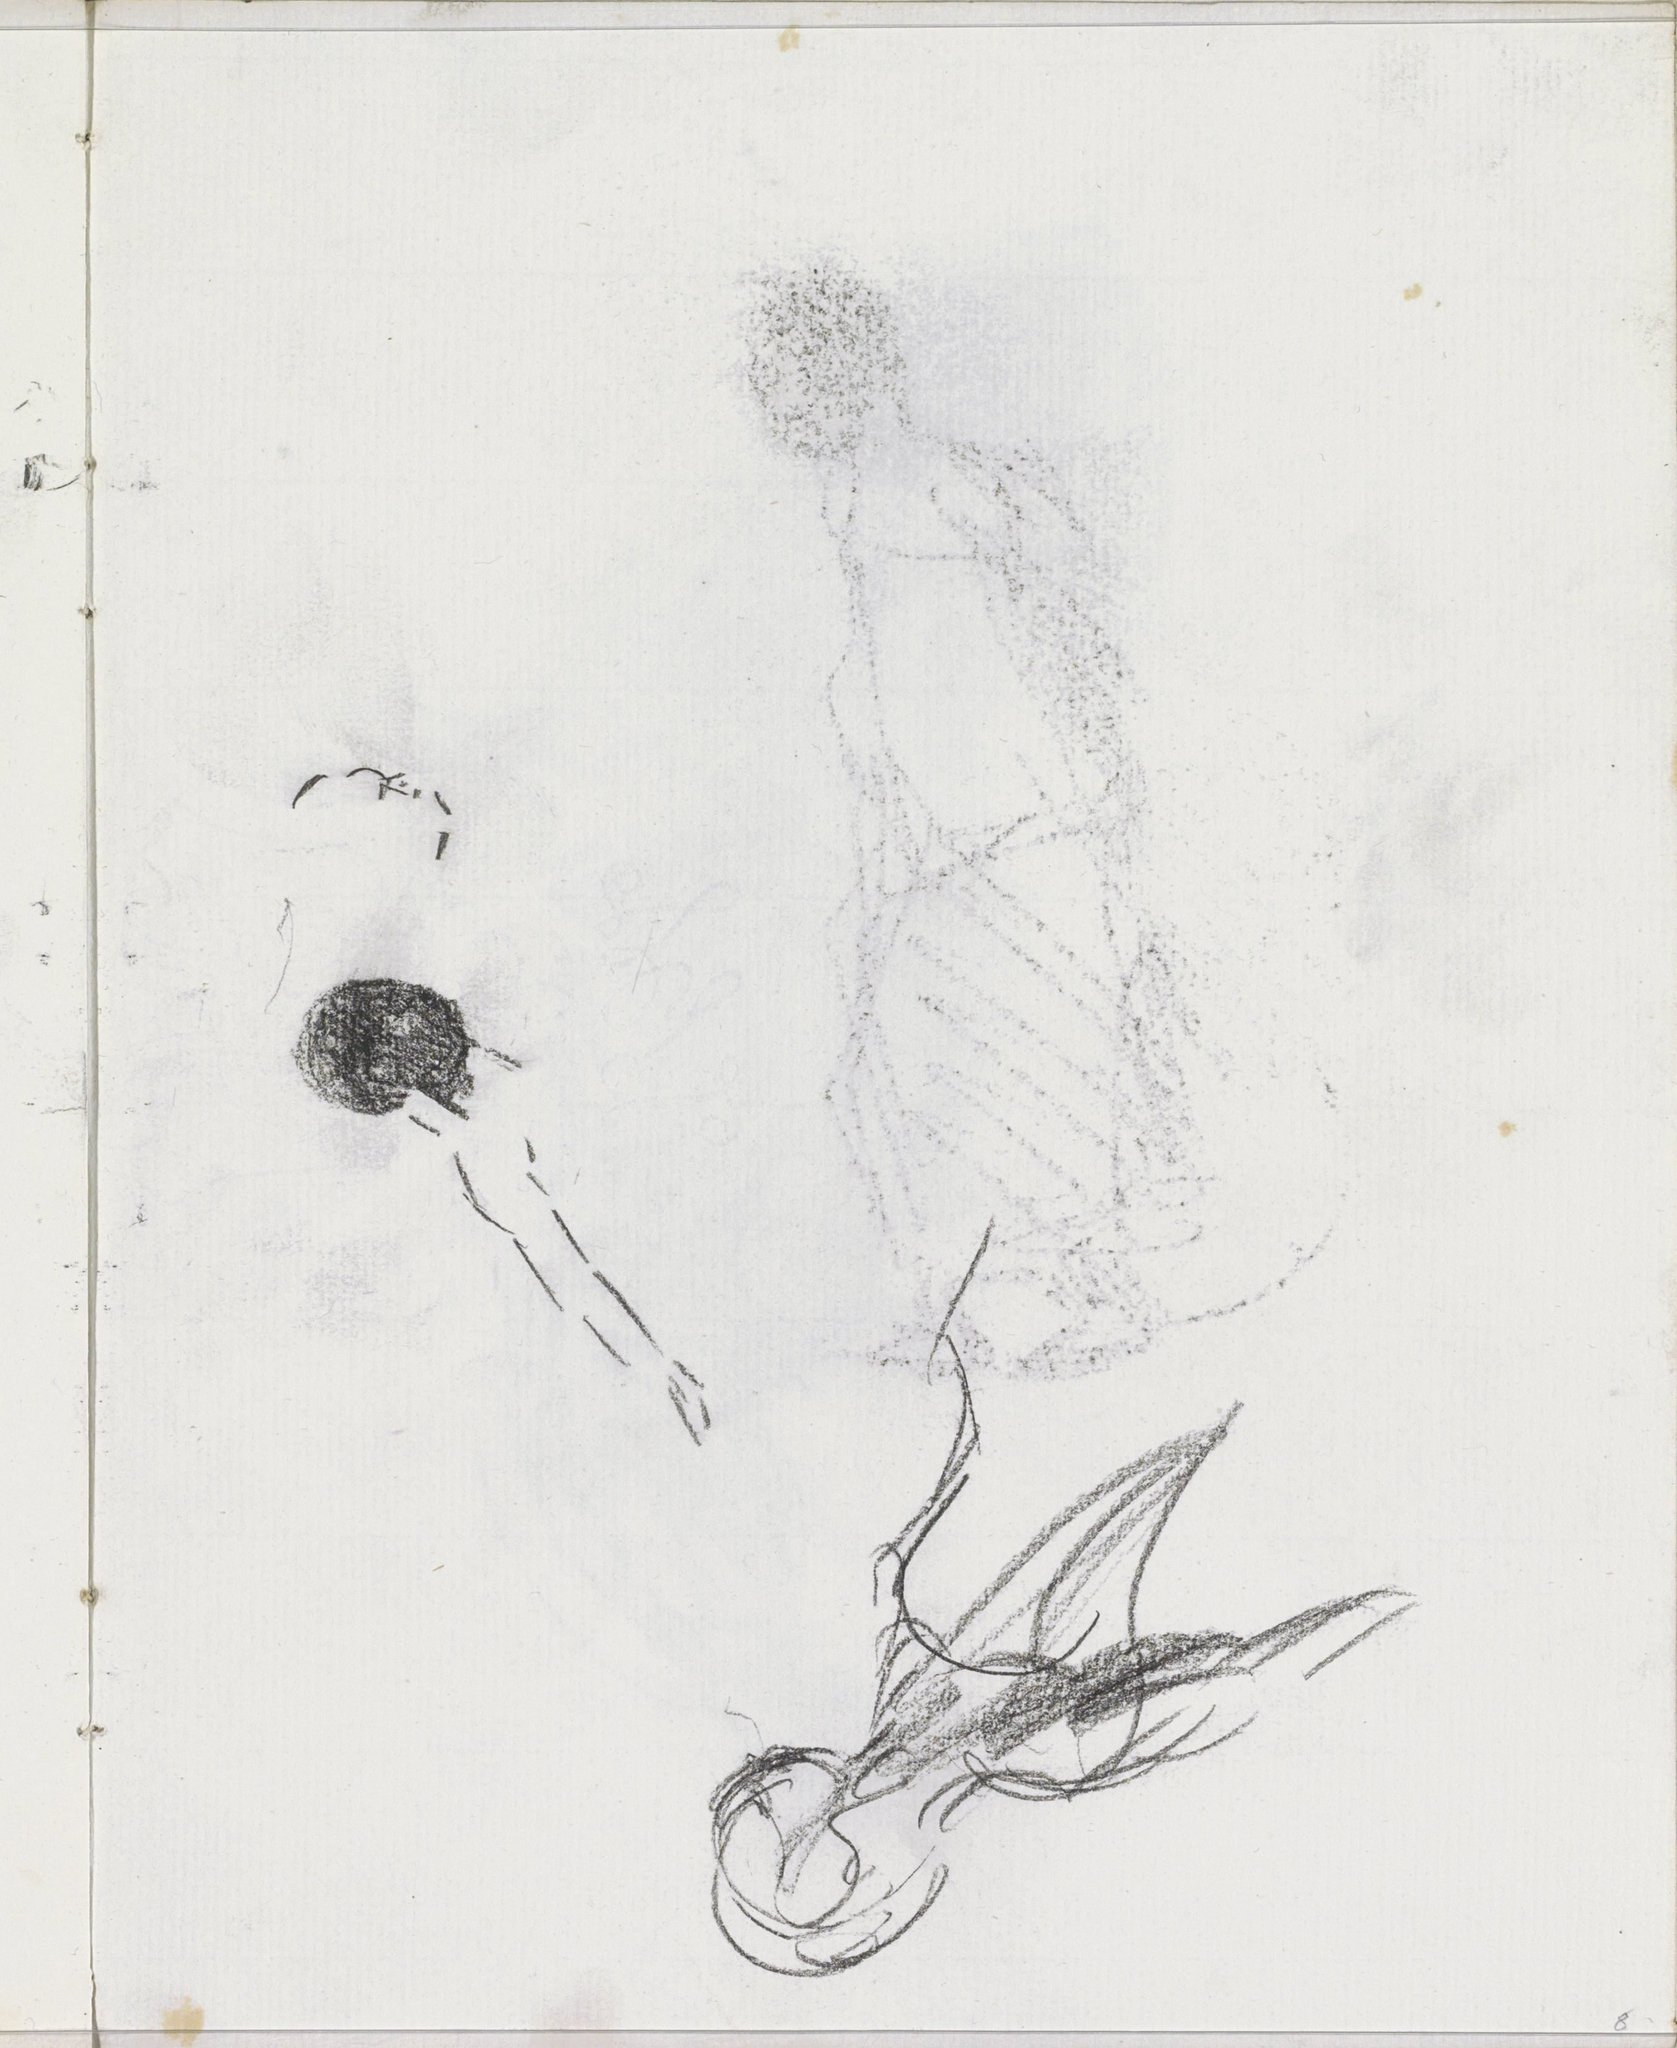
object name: sketchbook leaf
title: Figuurstudies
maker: isaac israels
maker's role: draughtsman, painter, print maker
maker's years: 1865-1934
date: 1875-1934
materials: chalk, paper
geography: the hague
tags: postures of the human figure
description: Blad 8 recto uit schetsboek XIII met 25 bladen.